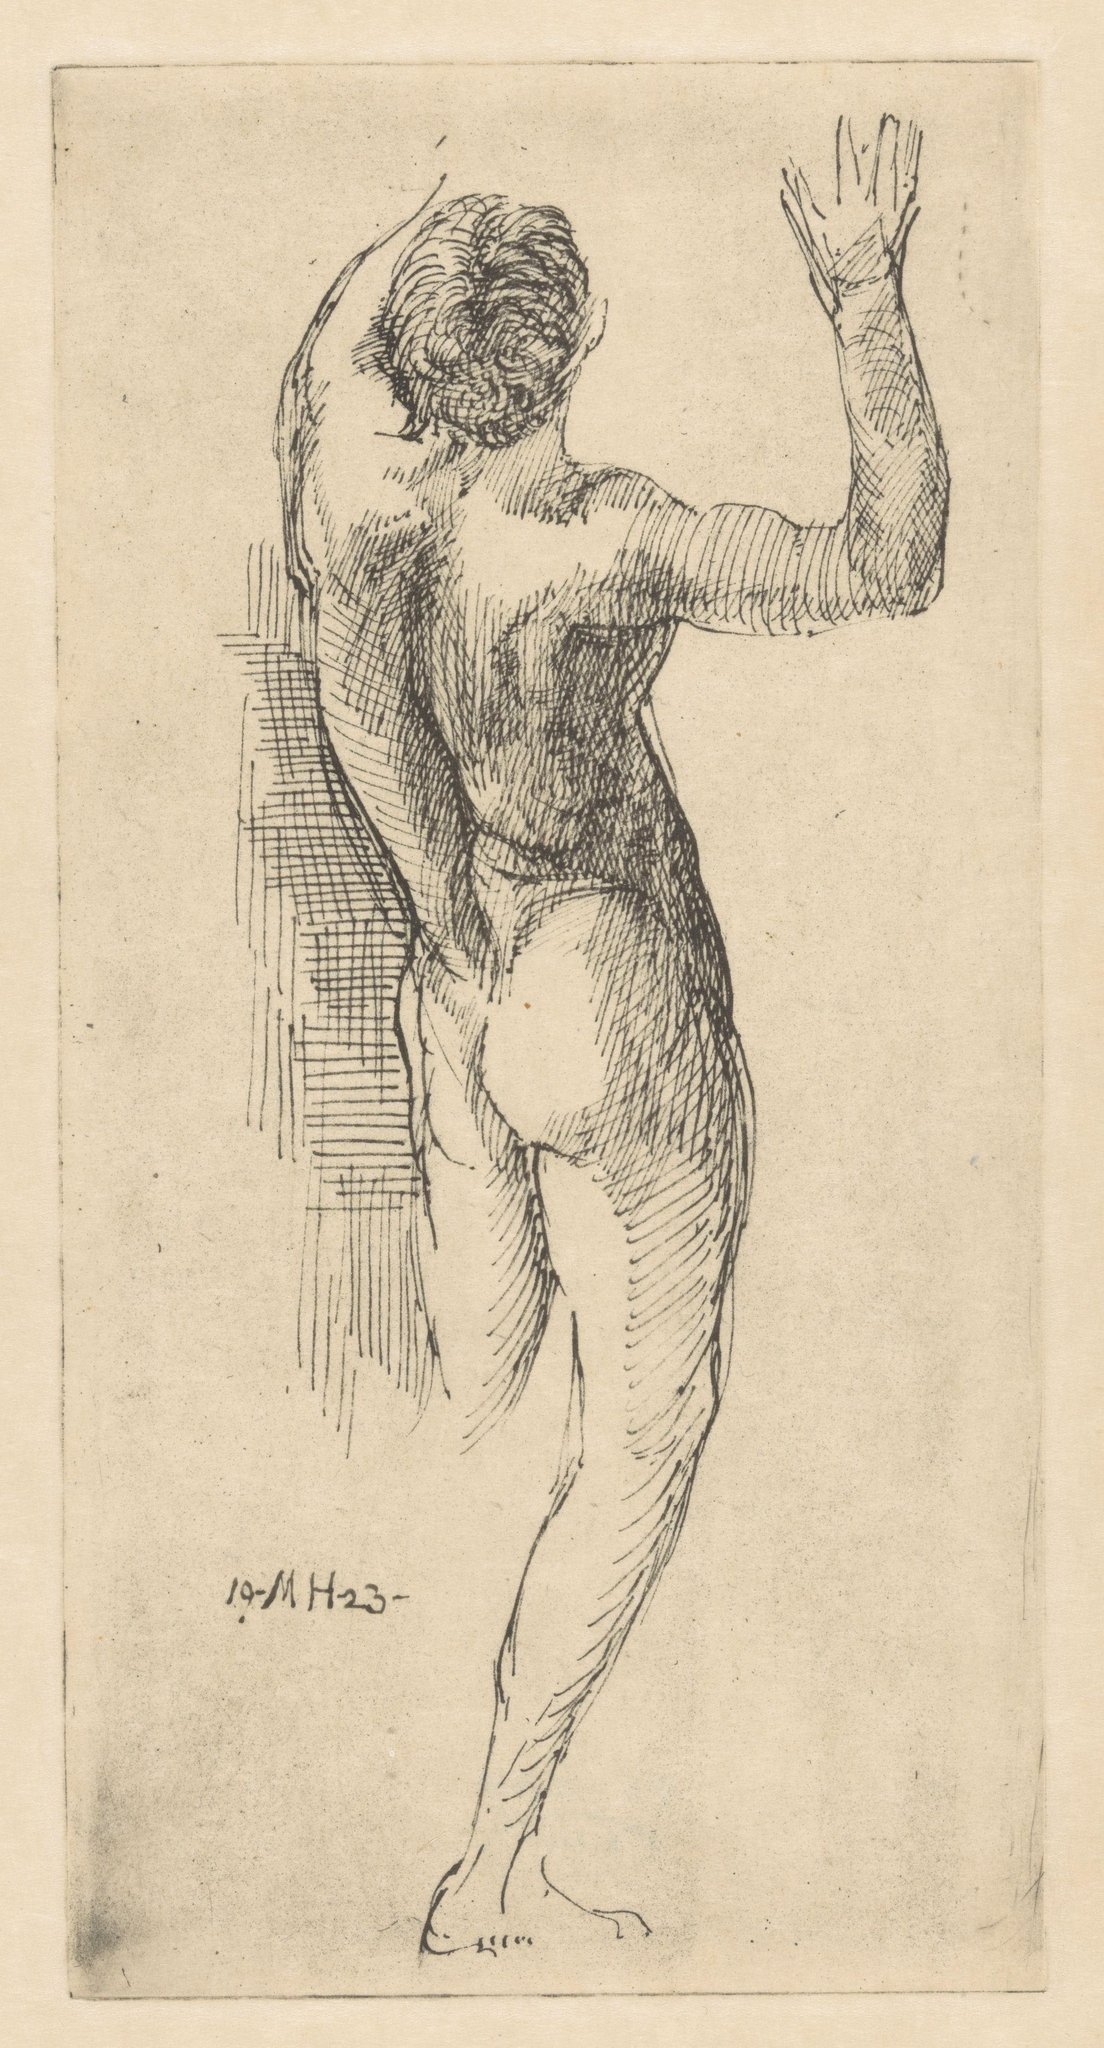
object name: print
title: Staand mannelijk naakt op de rug gezien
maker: marius holleman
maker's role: draughtsman, print maker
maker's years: 1878-1926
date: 1923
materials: paper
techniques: etching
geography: groningen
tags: standing figure, arm raised, with fingers spread out - aa - both arms or hands, human figure of ideal proportions, e.g. academic nude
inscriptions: collector's mark: Lugt 2228